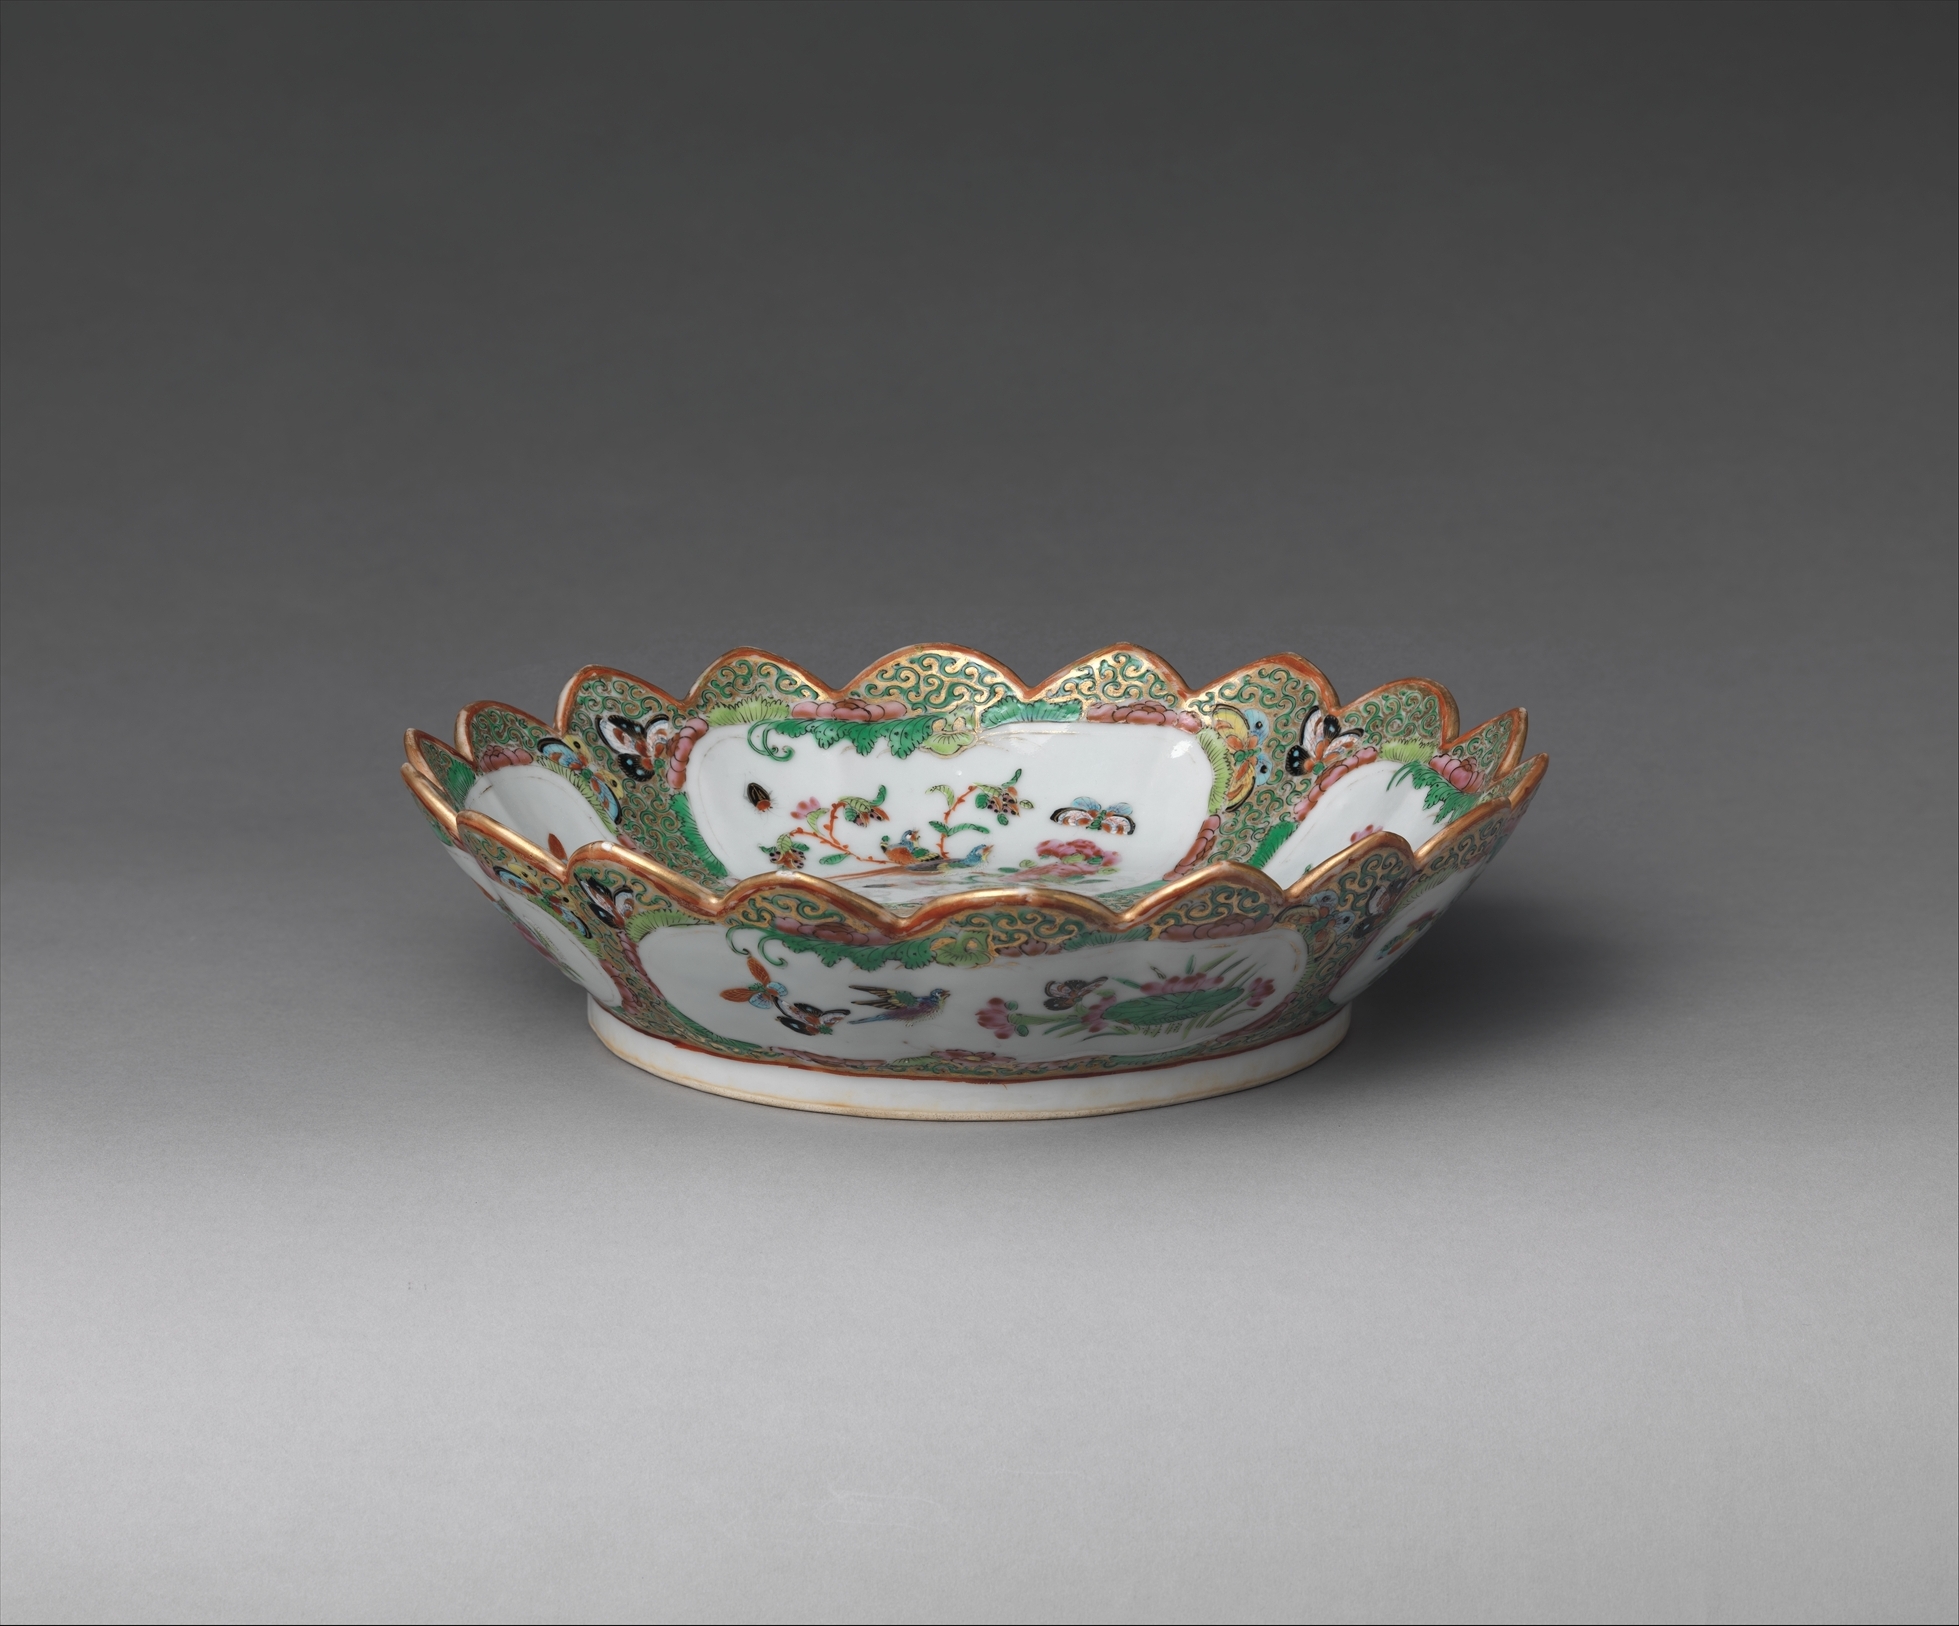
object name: dish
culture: chinese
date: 1860-1866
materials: porcelain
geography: china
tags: birds,flowers